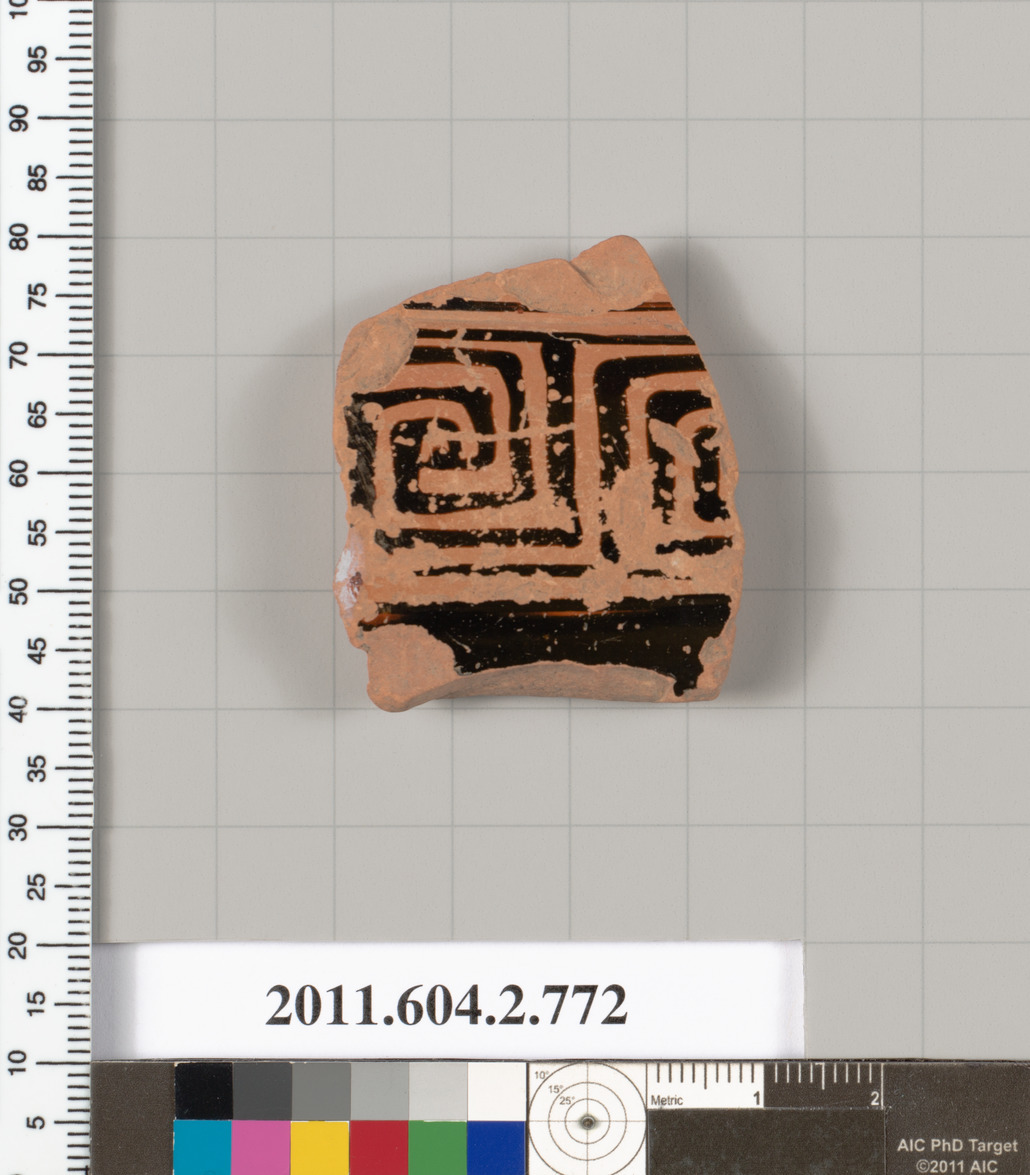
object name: calyx krater fragment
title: Terracotta fragment of a calyx-krater (bowl for mixing wine and water)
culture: greek, attic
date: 470-450 BCE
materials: terracotta